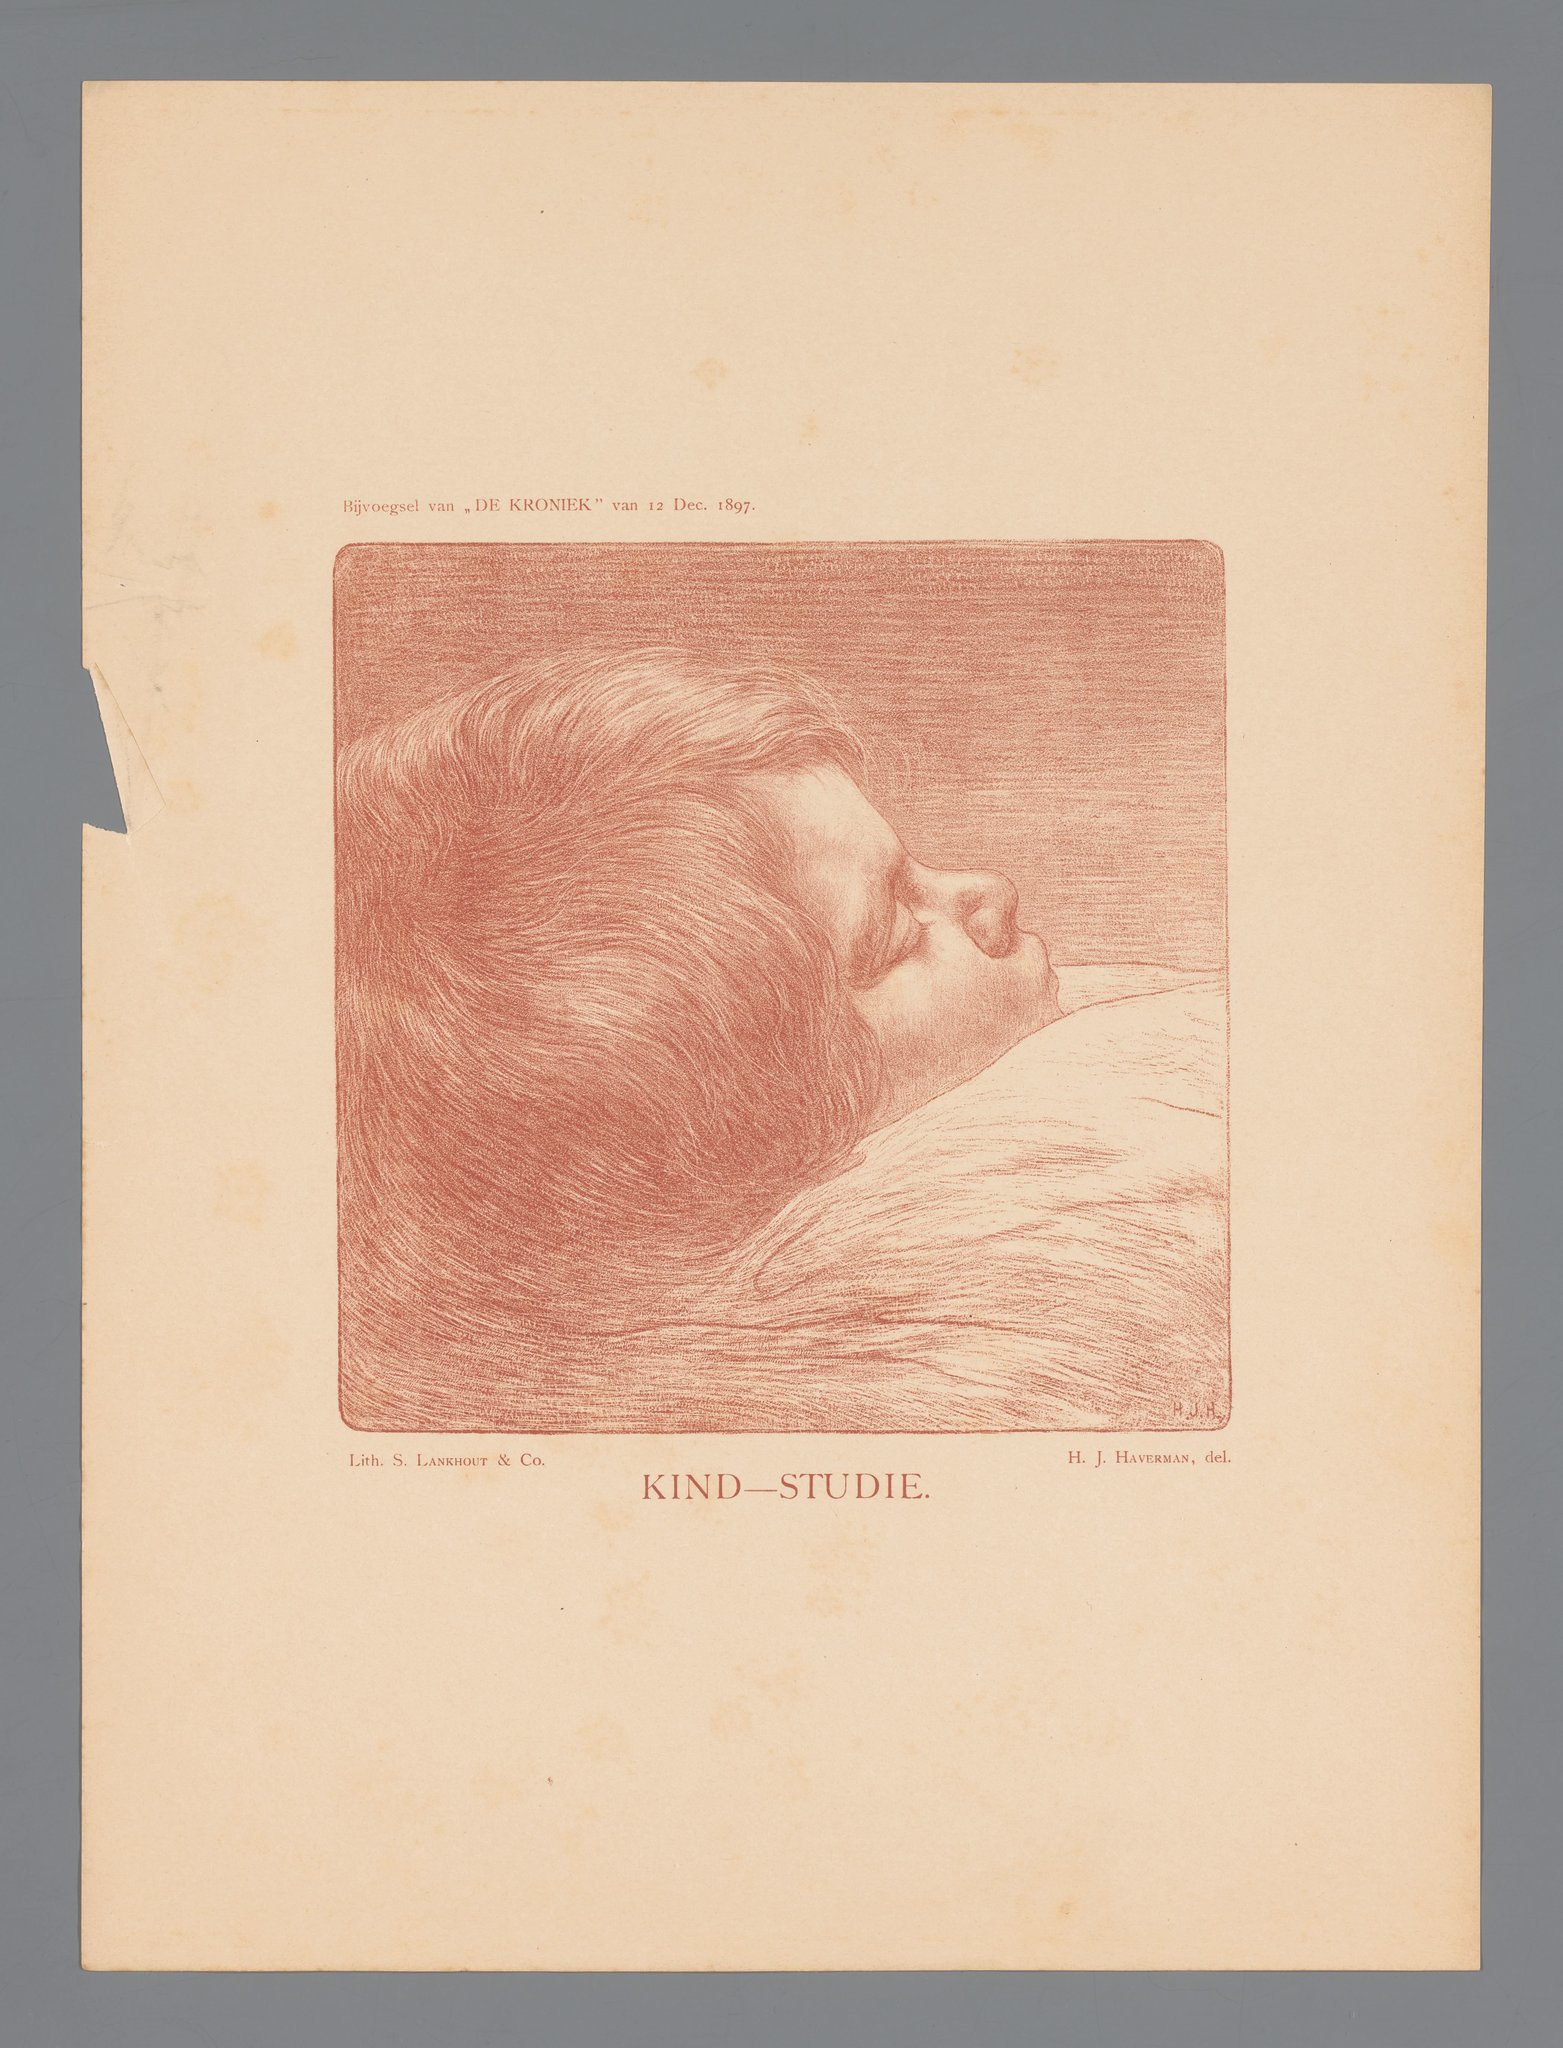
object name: print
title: Kind-studie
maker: hendrik johannes haverman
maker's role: draughtsman, print maker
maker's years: 1857-1928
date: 1897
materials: paper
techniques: lithograph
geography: the hague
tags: face, child (at home)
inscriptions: date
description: Prent uit het bijvoegsel van: De Kroniek 3 (1897), 12 december 1897.